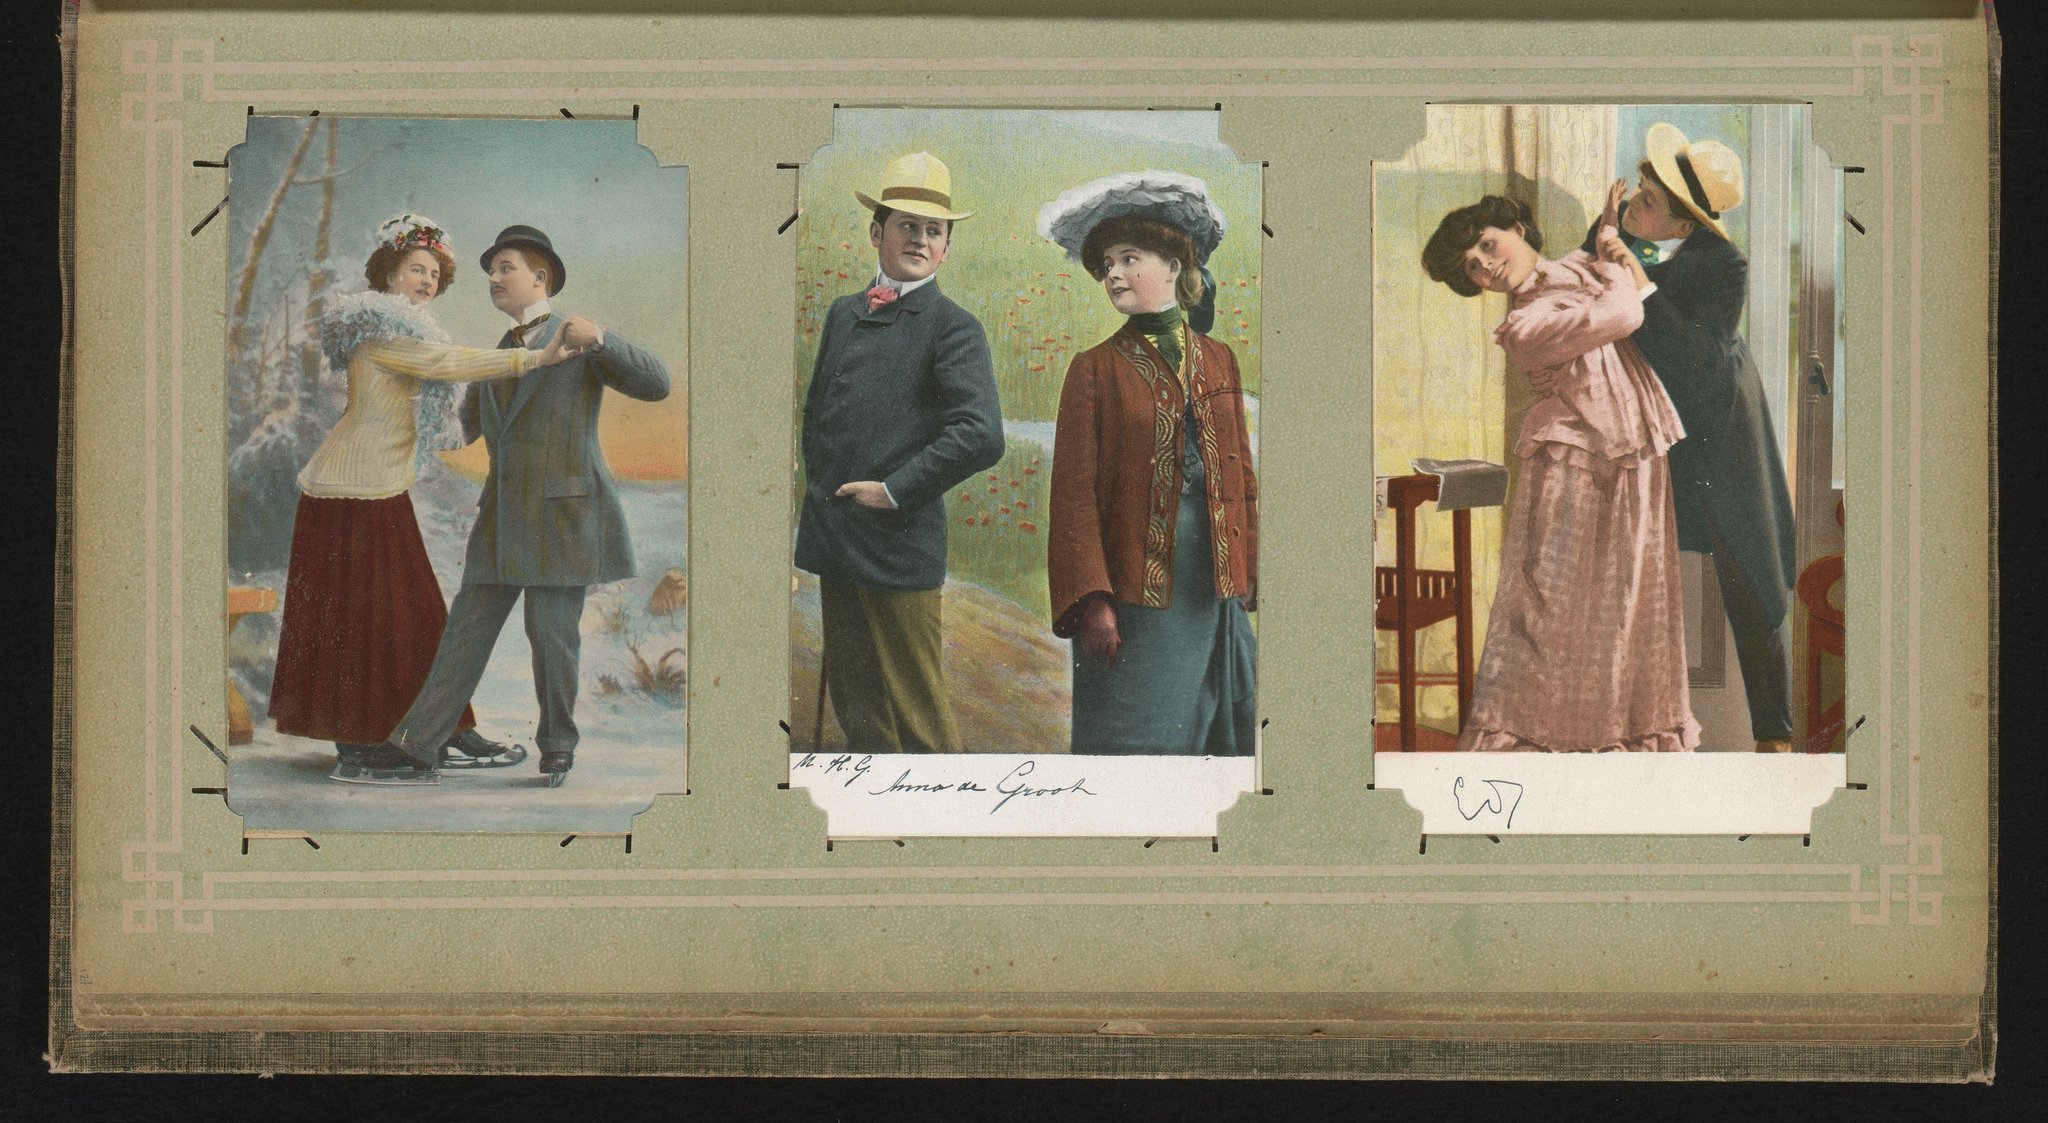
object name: ansichtkaart, prentbriefkaart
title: Drie portretten van een paar geliefden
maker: Anonymous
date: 1900-1930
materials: cardboard, ink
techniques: pen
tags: historical persons, skates (winter sports), couple of lovers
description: Deze prenten maken deel uit van een album.